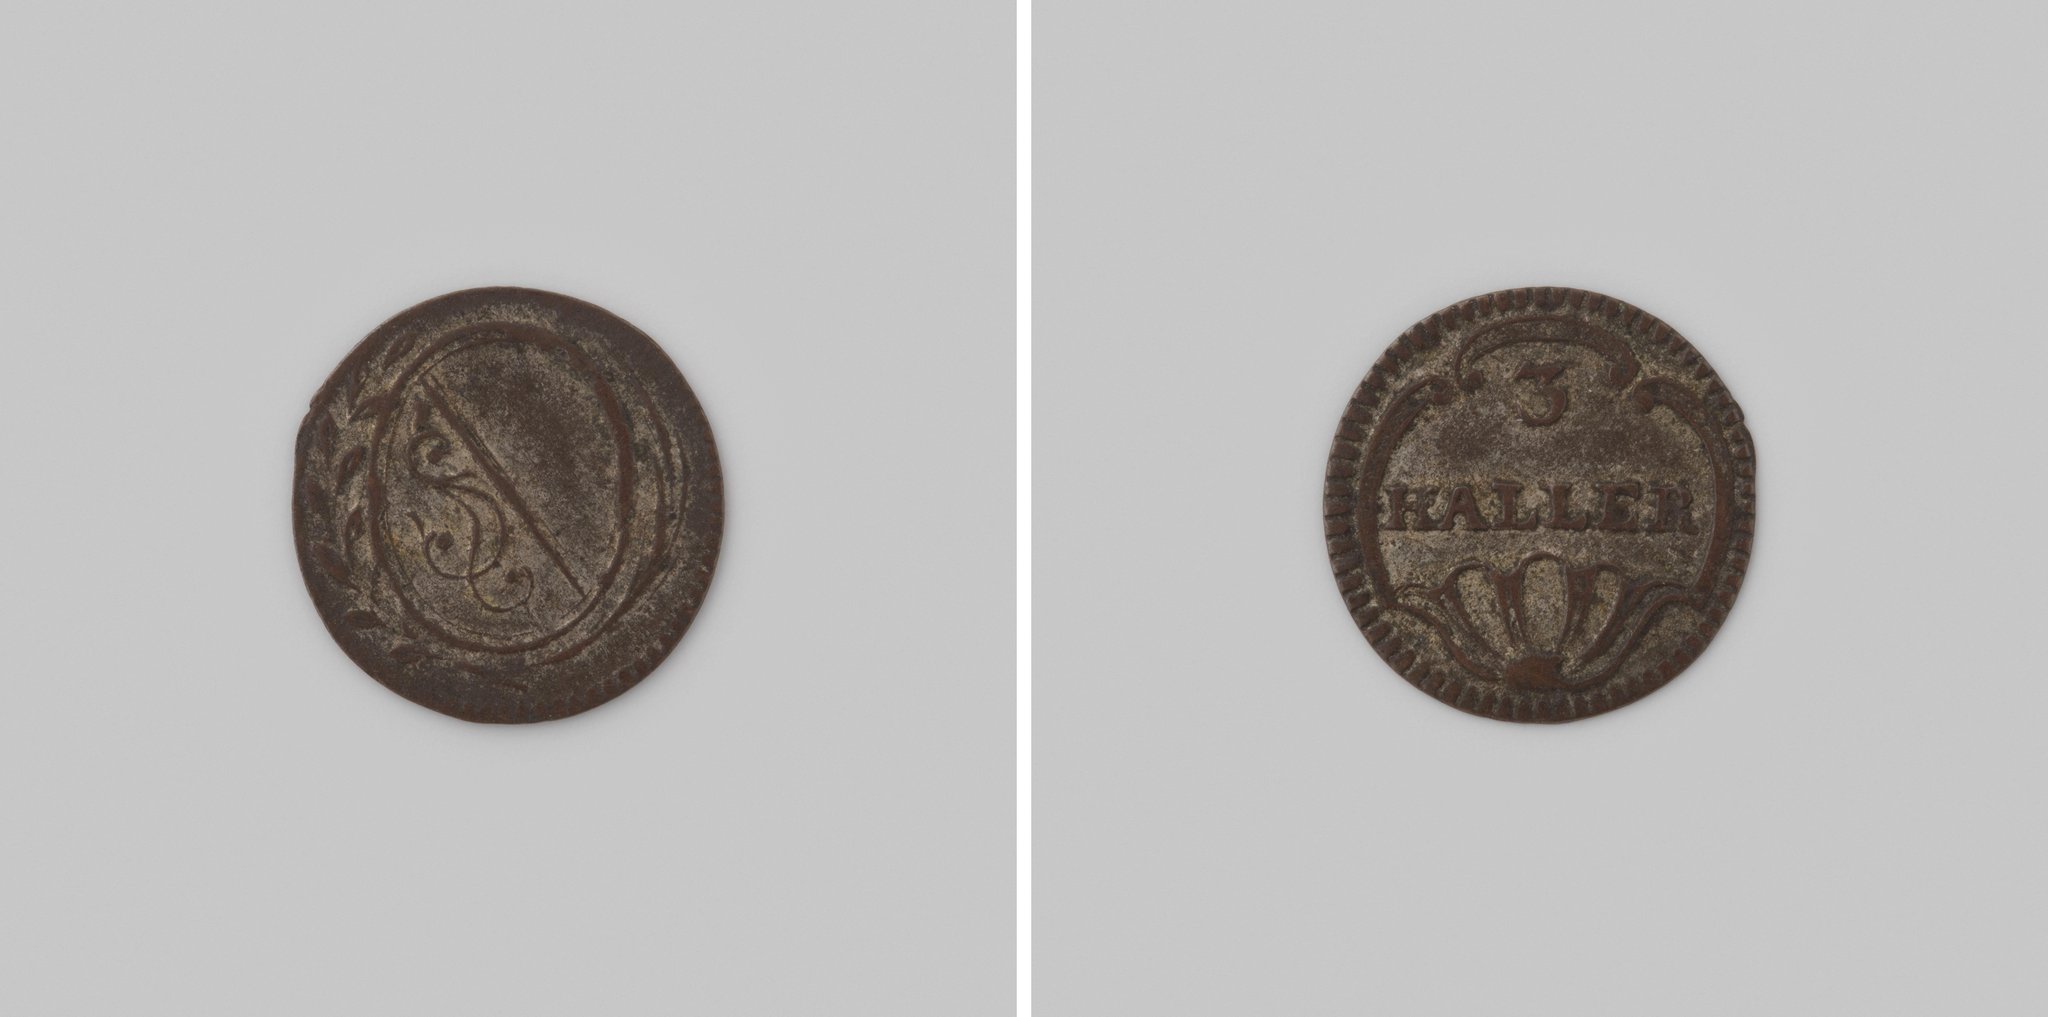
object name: coin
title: Rappen of 3 Haller uit het kanton Zürich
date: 1827-1841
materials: silver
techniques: striking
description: Zilveren munt. Voorzijde: tussen twee samengebonden takken wapenschild. Keerzijde: binnen barok-versiering in twee regels waarde-aanduiding: 3 haller. Gladde rand.